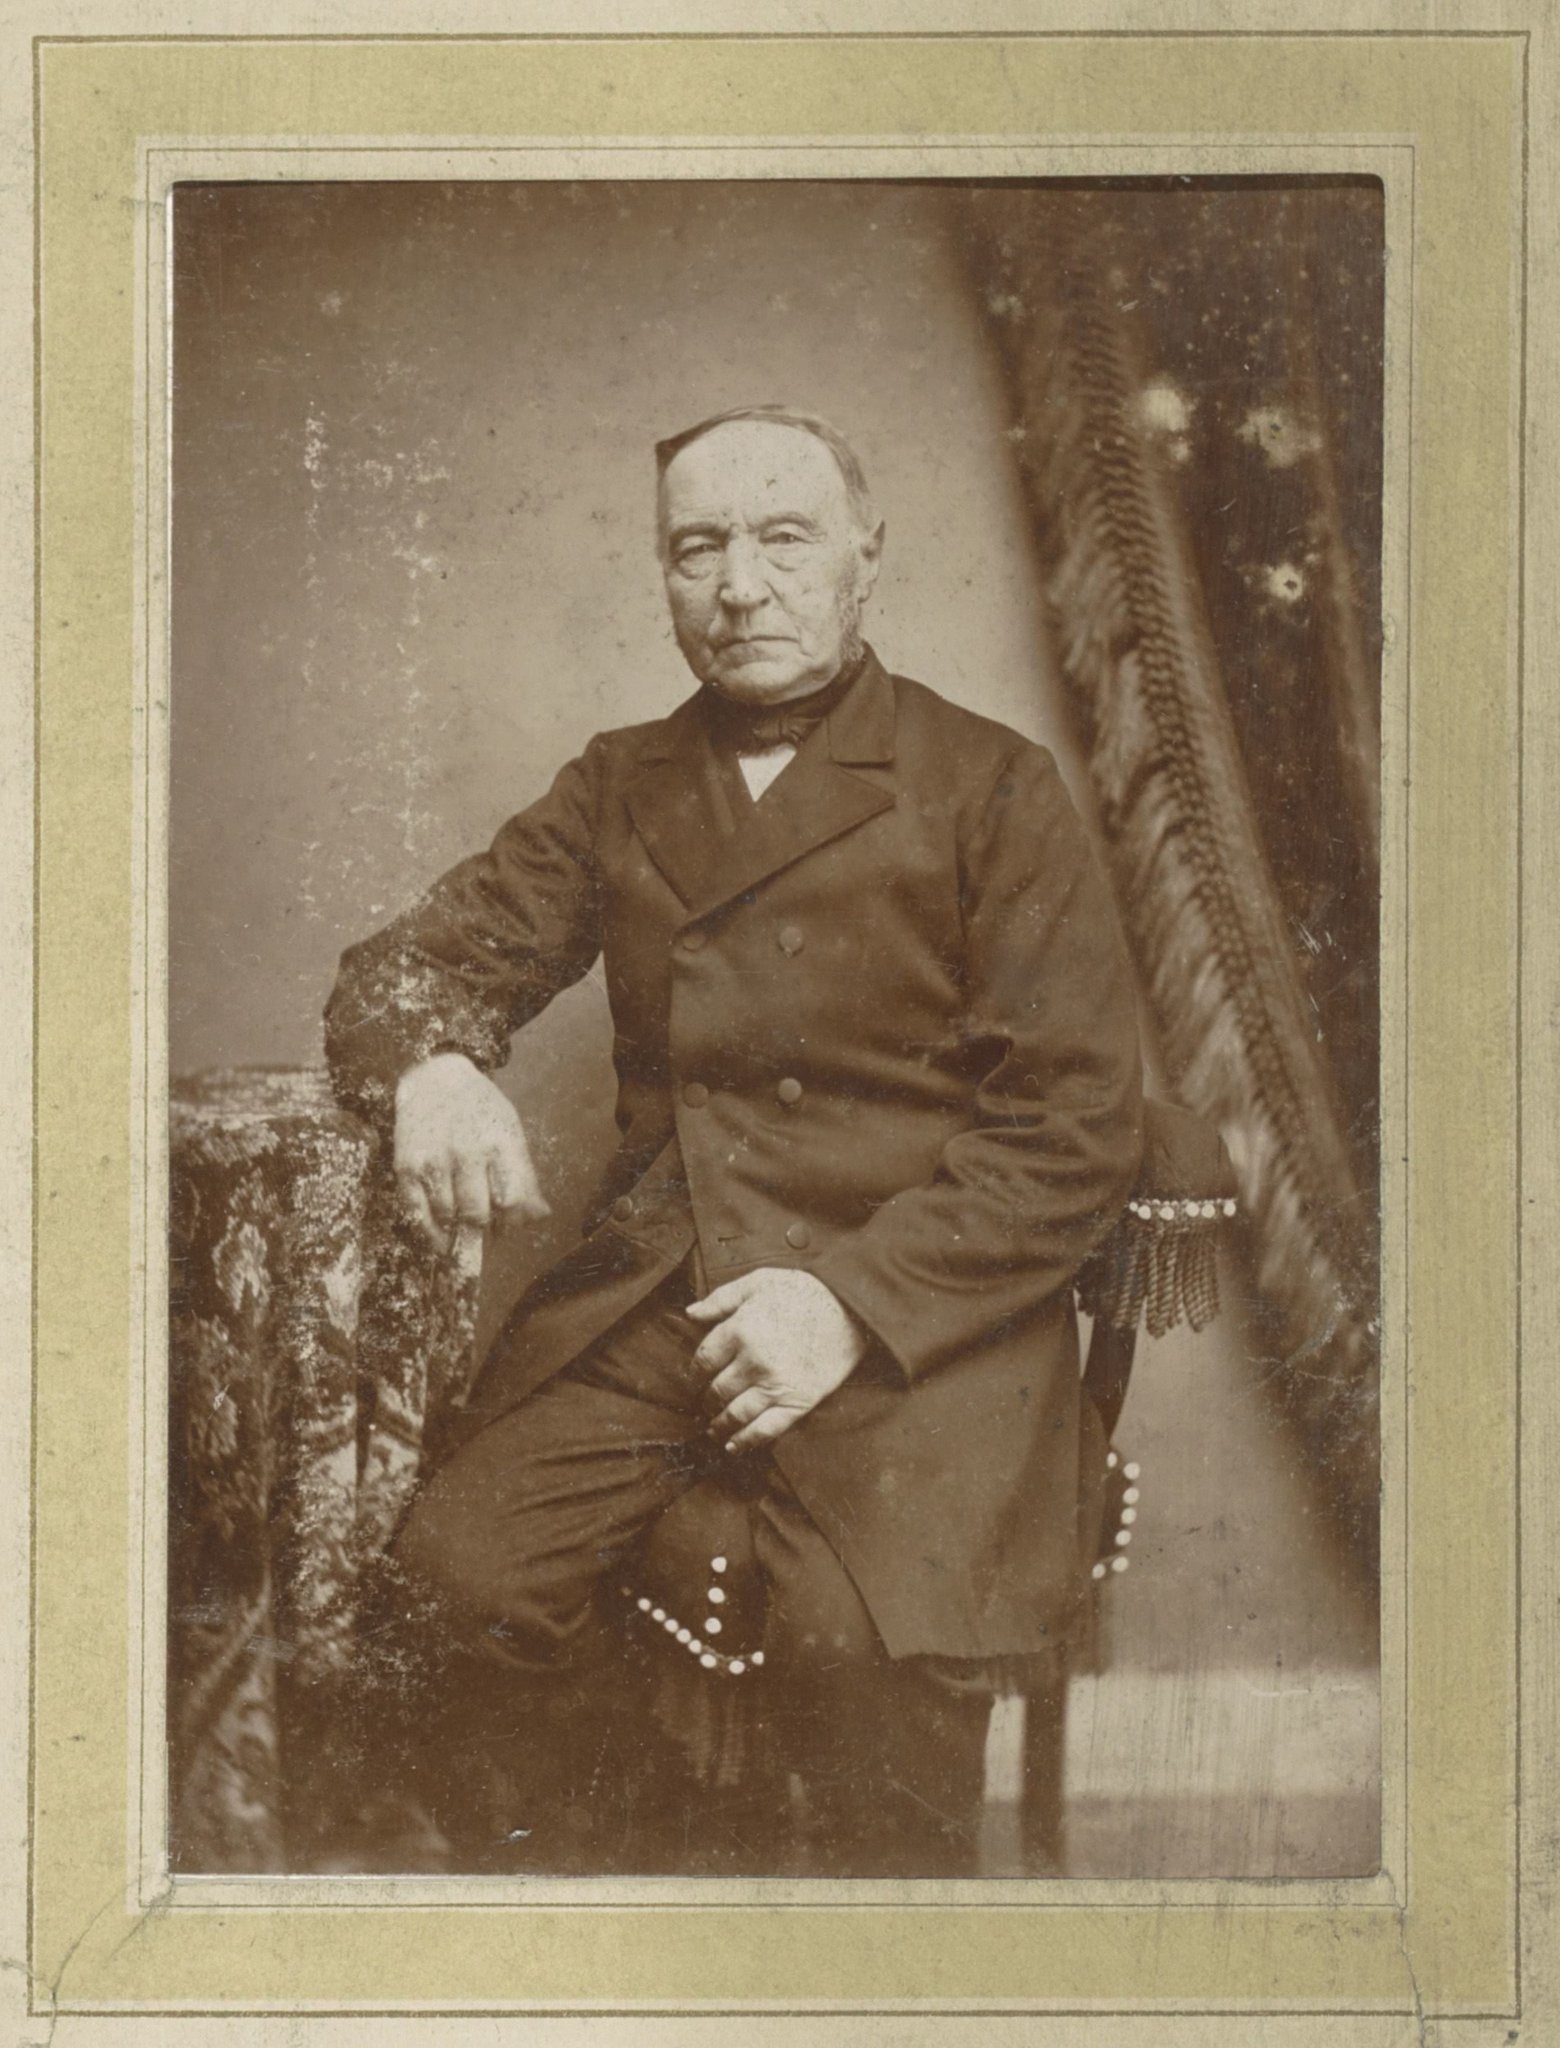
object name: photograph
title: Portret van een man in een jas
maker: Anonymous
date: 1870-1900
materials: cardboard, paper, photographic support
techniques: collodion silver print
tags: sideburns, studio requisites ~ photographer, clothing for the lower part of the body, historical persons, coat, cape, amsterdam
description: Onderdeel van Fotoalbum van een Nederlandse familie met 168 cartes-de-visite en kabinetfoto's.